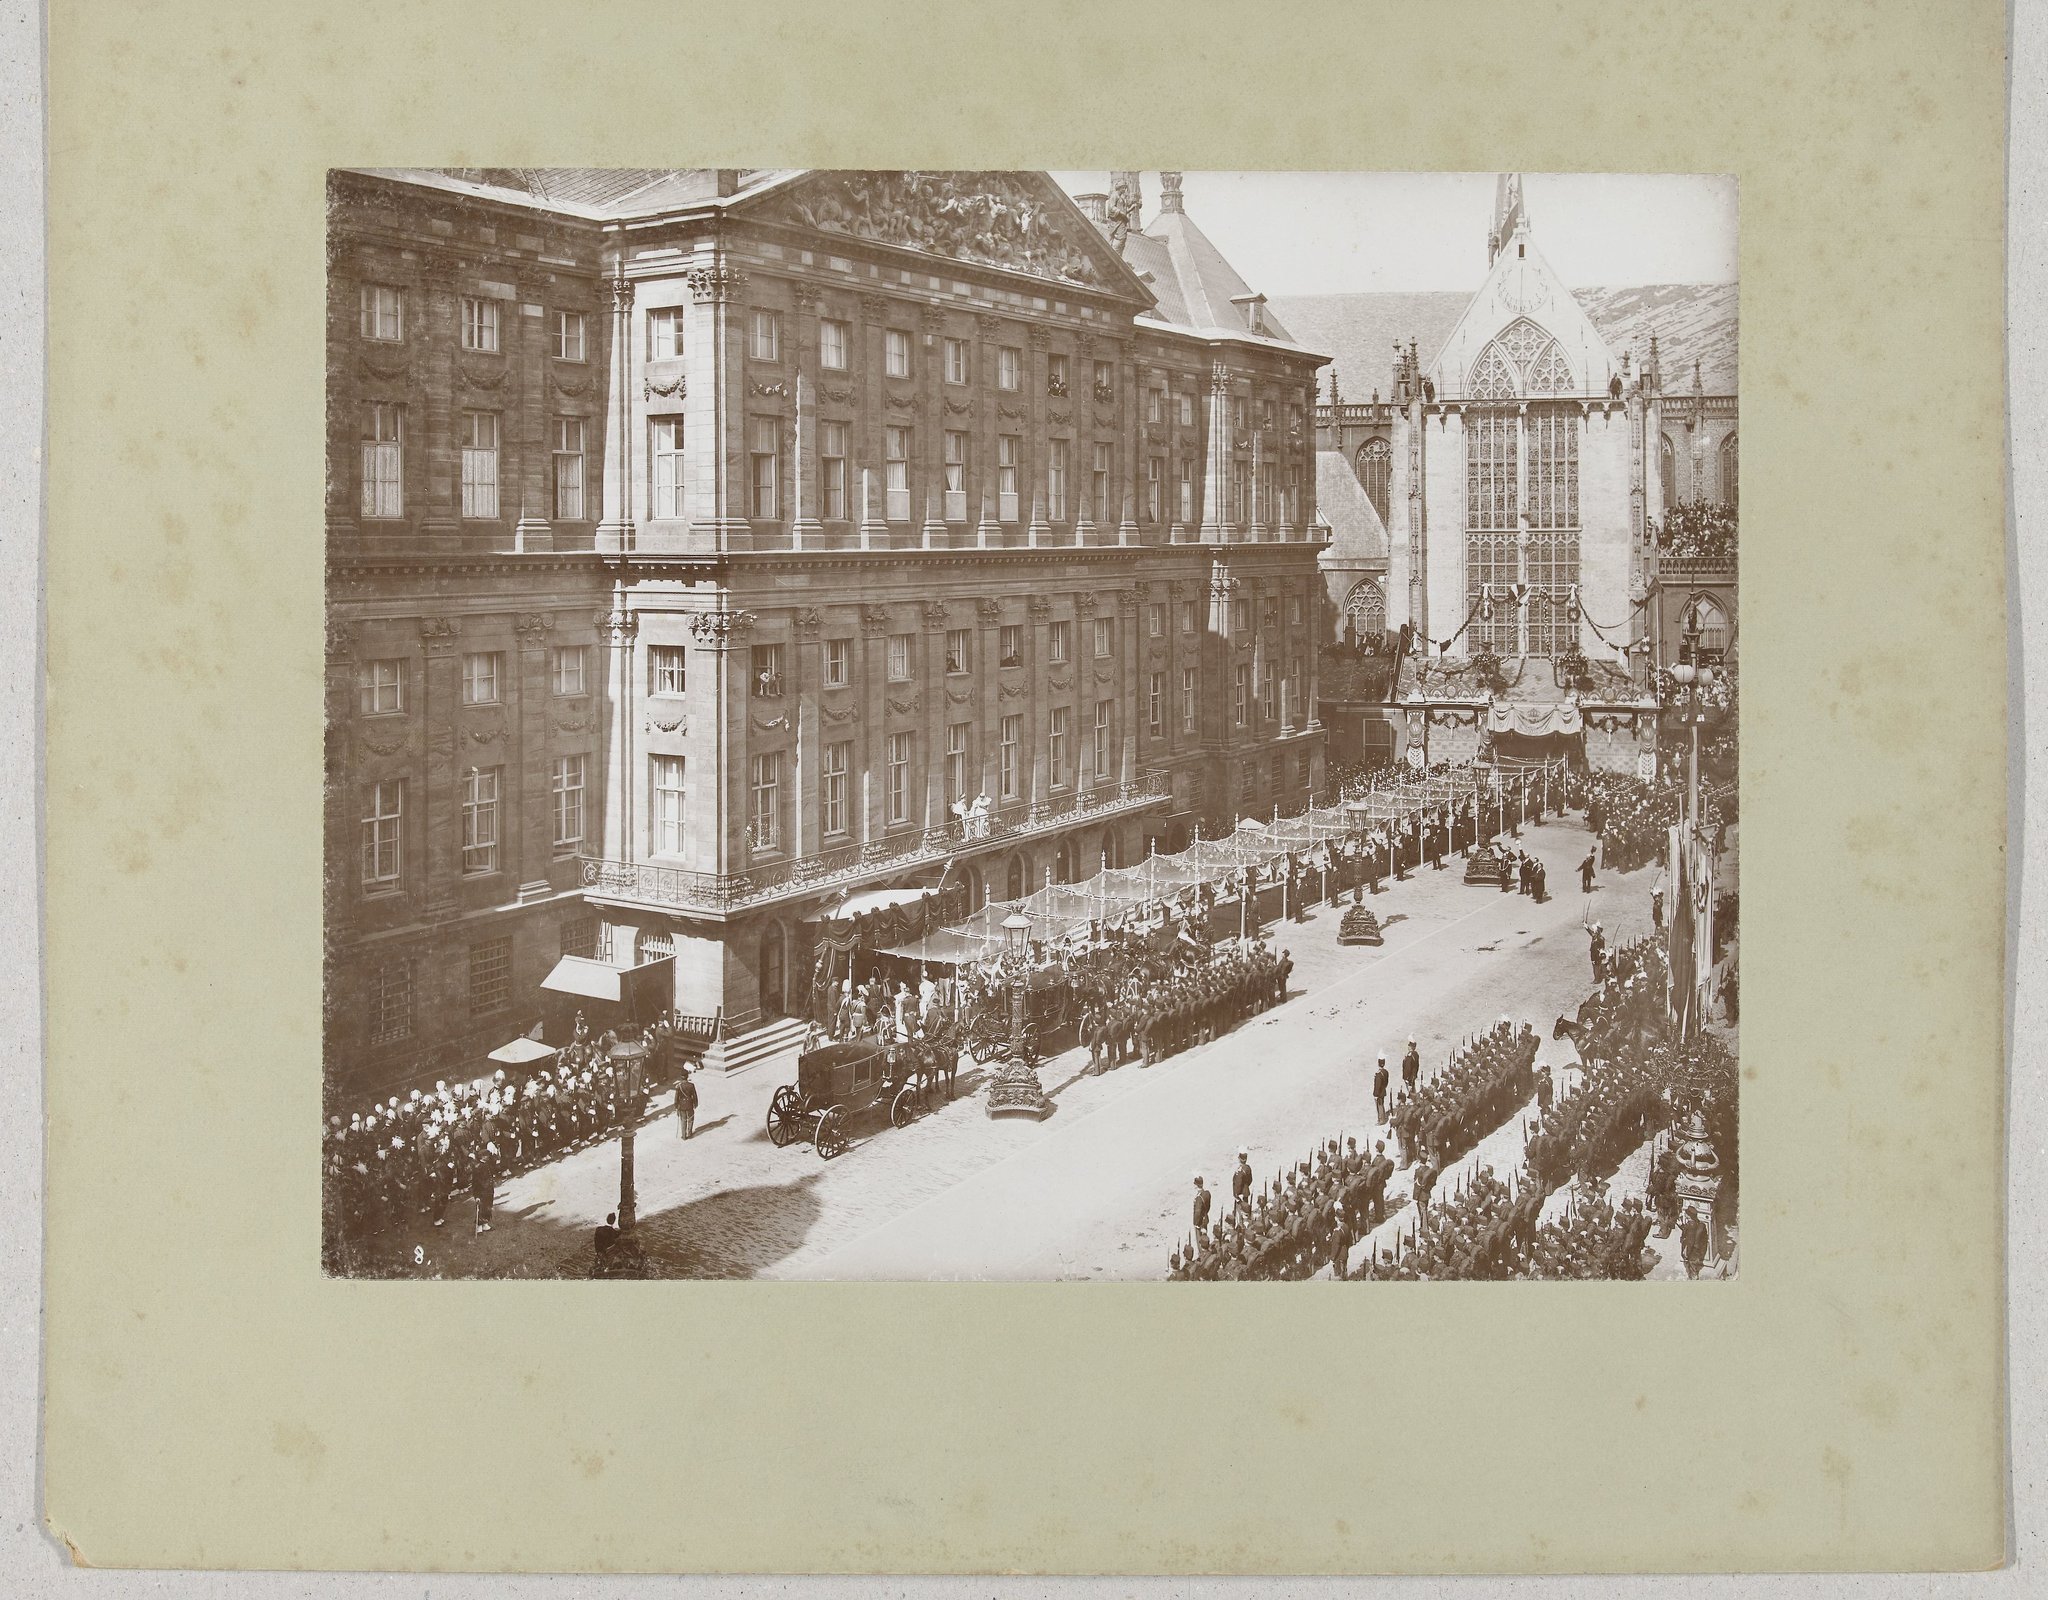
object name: photograph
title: Begroeting van Wilhelmina door militairen en burgers na haar inhuldiging als koningin, bij het Paleis op de Dam, Amsterdam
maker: sigmund löw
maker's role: publisher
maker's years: 1845-1920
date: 1898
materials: paper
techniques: collodion silver print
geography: amsterdam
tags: the hague, print maker, wilhelmina of the netherlands, after the coronation, palace, royal palace of amsterdam, amsterdam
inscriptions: name: ‘Atelier Herz Amsterdam’